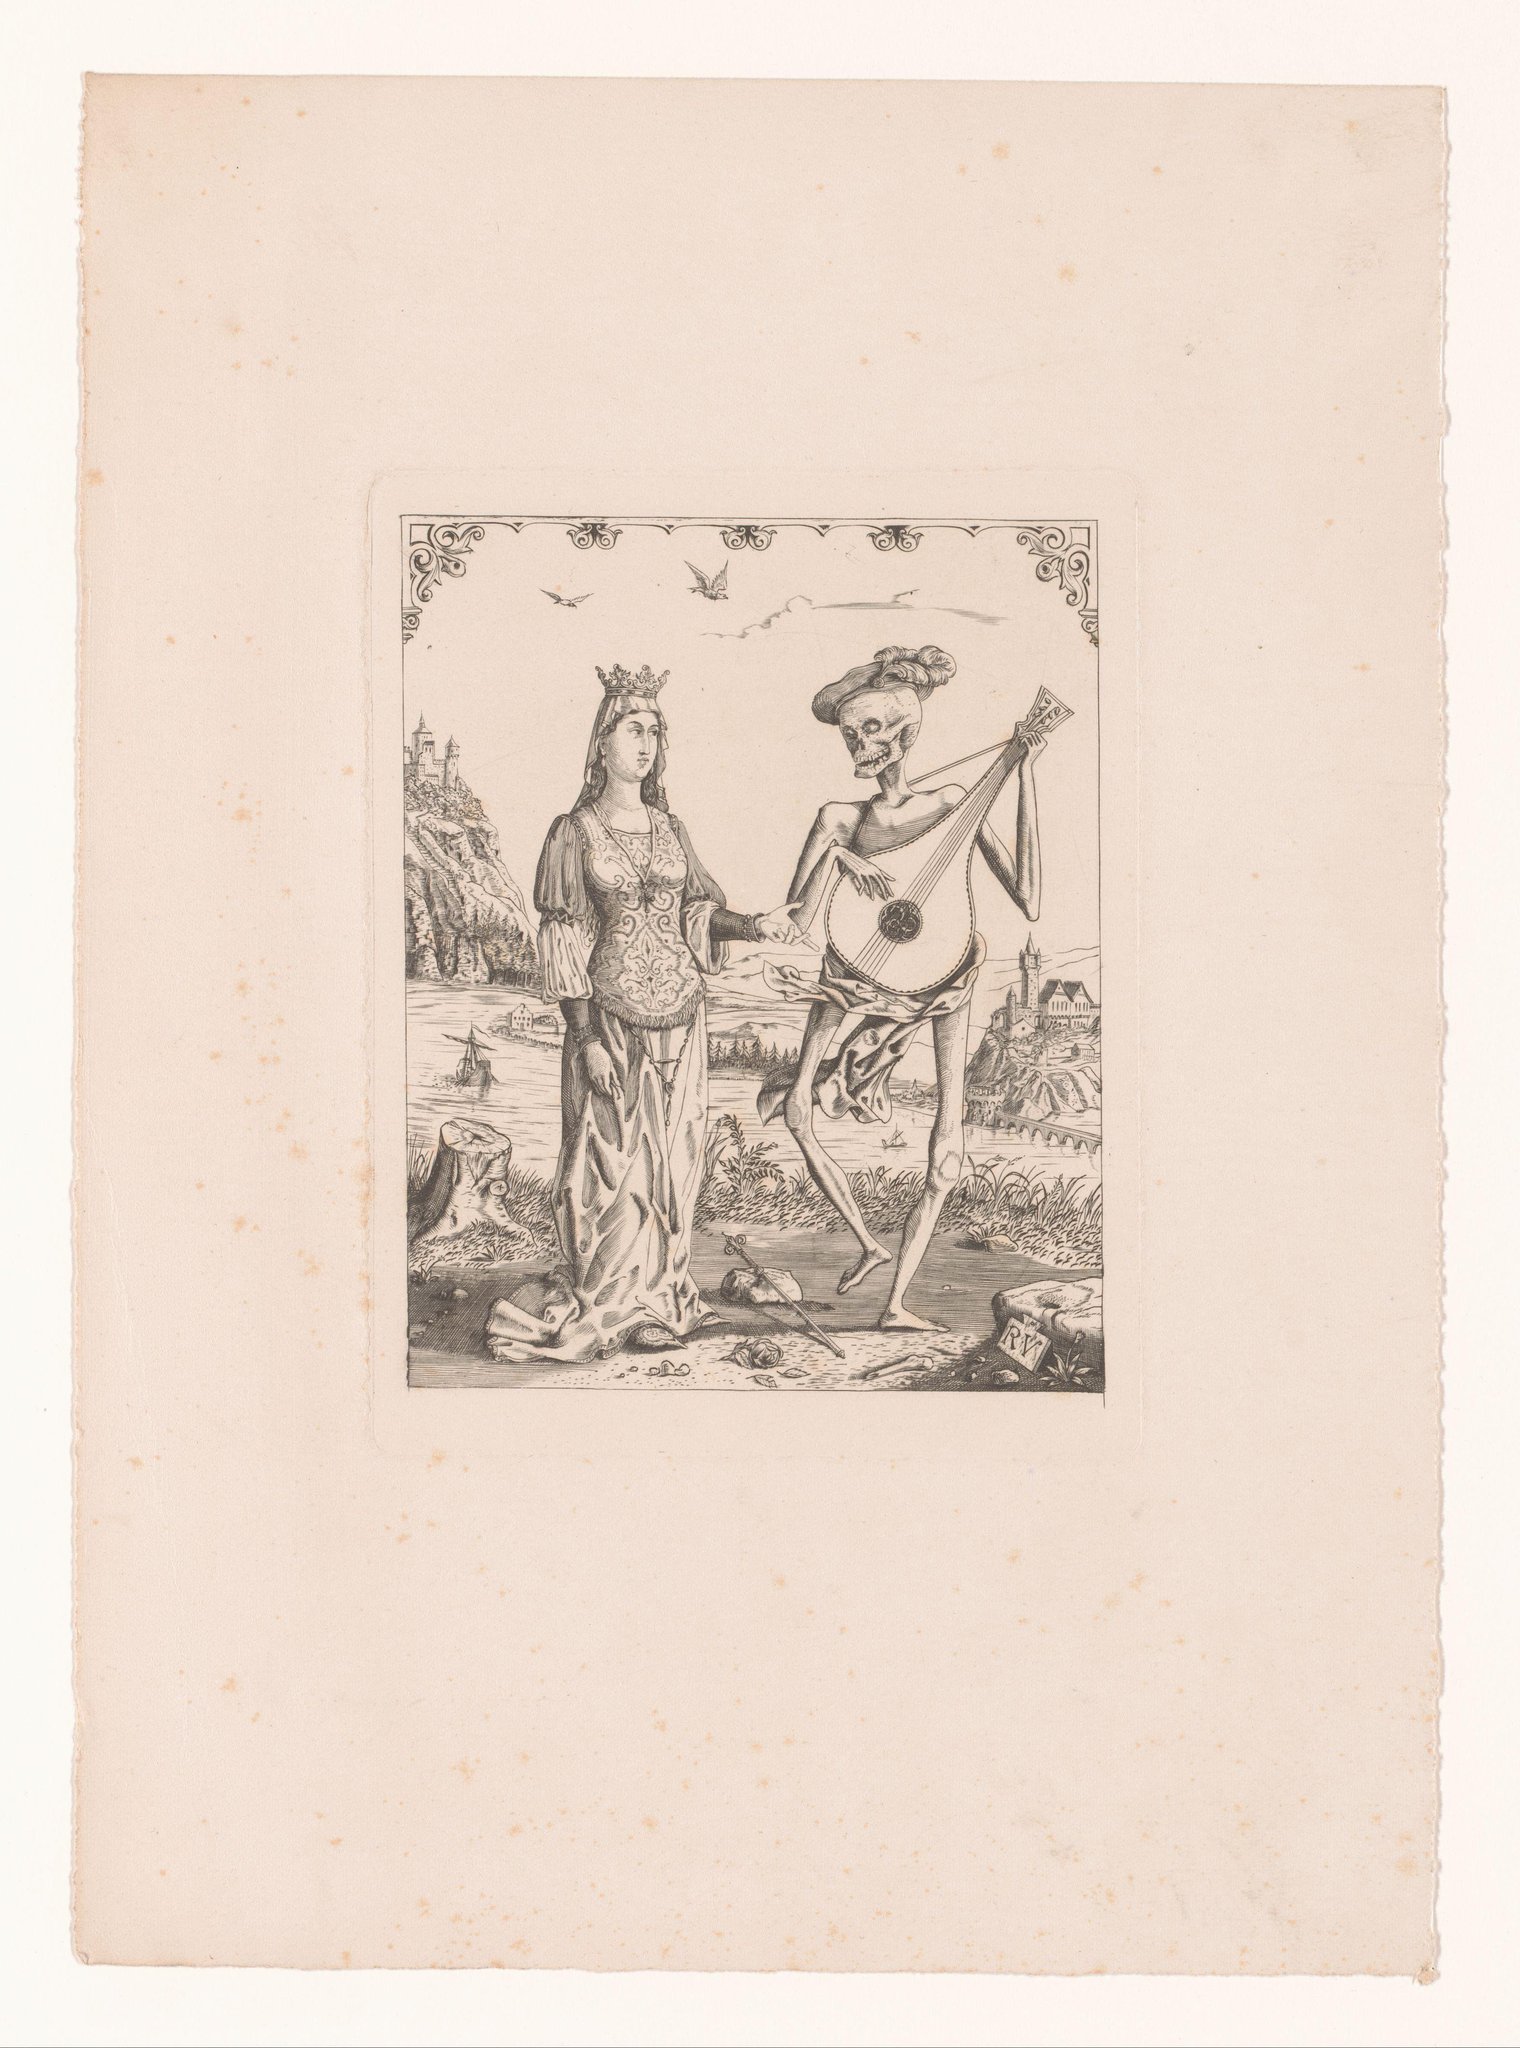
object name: print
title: Allegorie met een edelvrouw en een musicerende Dood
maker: rodolphe verhoeven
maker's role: print maker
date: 1850-1900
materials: paper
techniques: engraving, etching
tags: making music; musician with instrument, scenes symbolizing 'vanitas', death as (rotting) corpse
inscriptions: collector's mark: Lugt 2228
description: Sterfdatum van de prentmaker is onbekend. Daarom is voor de bepaling van de rechten van dit object gebruik gemaakt van de verwervingsdatum Rijksmuseum Amsterdam.